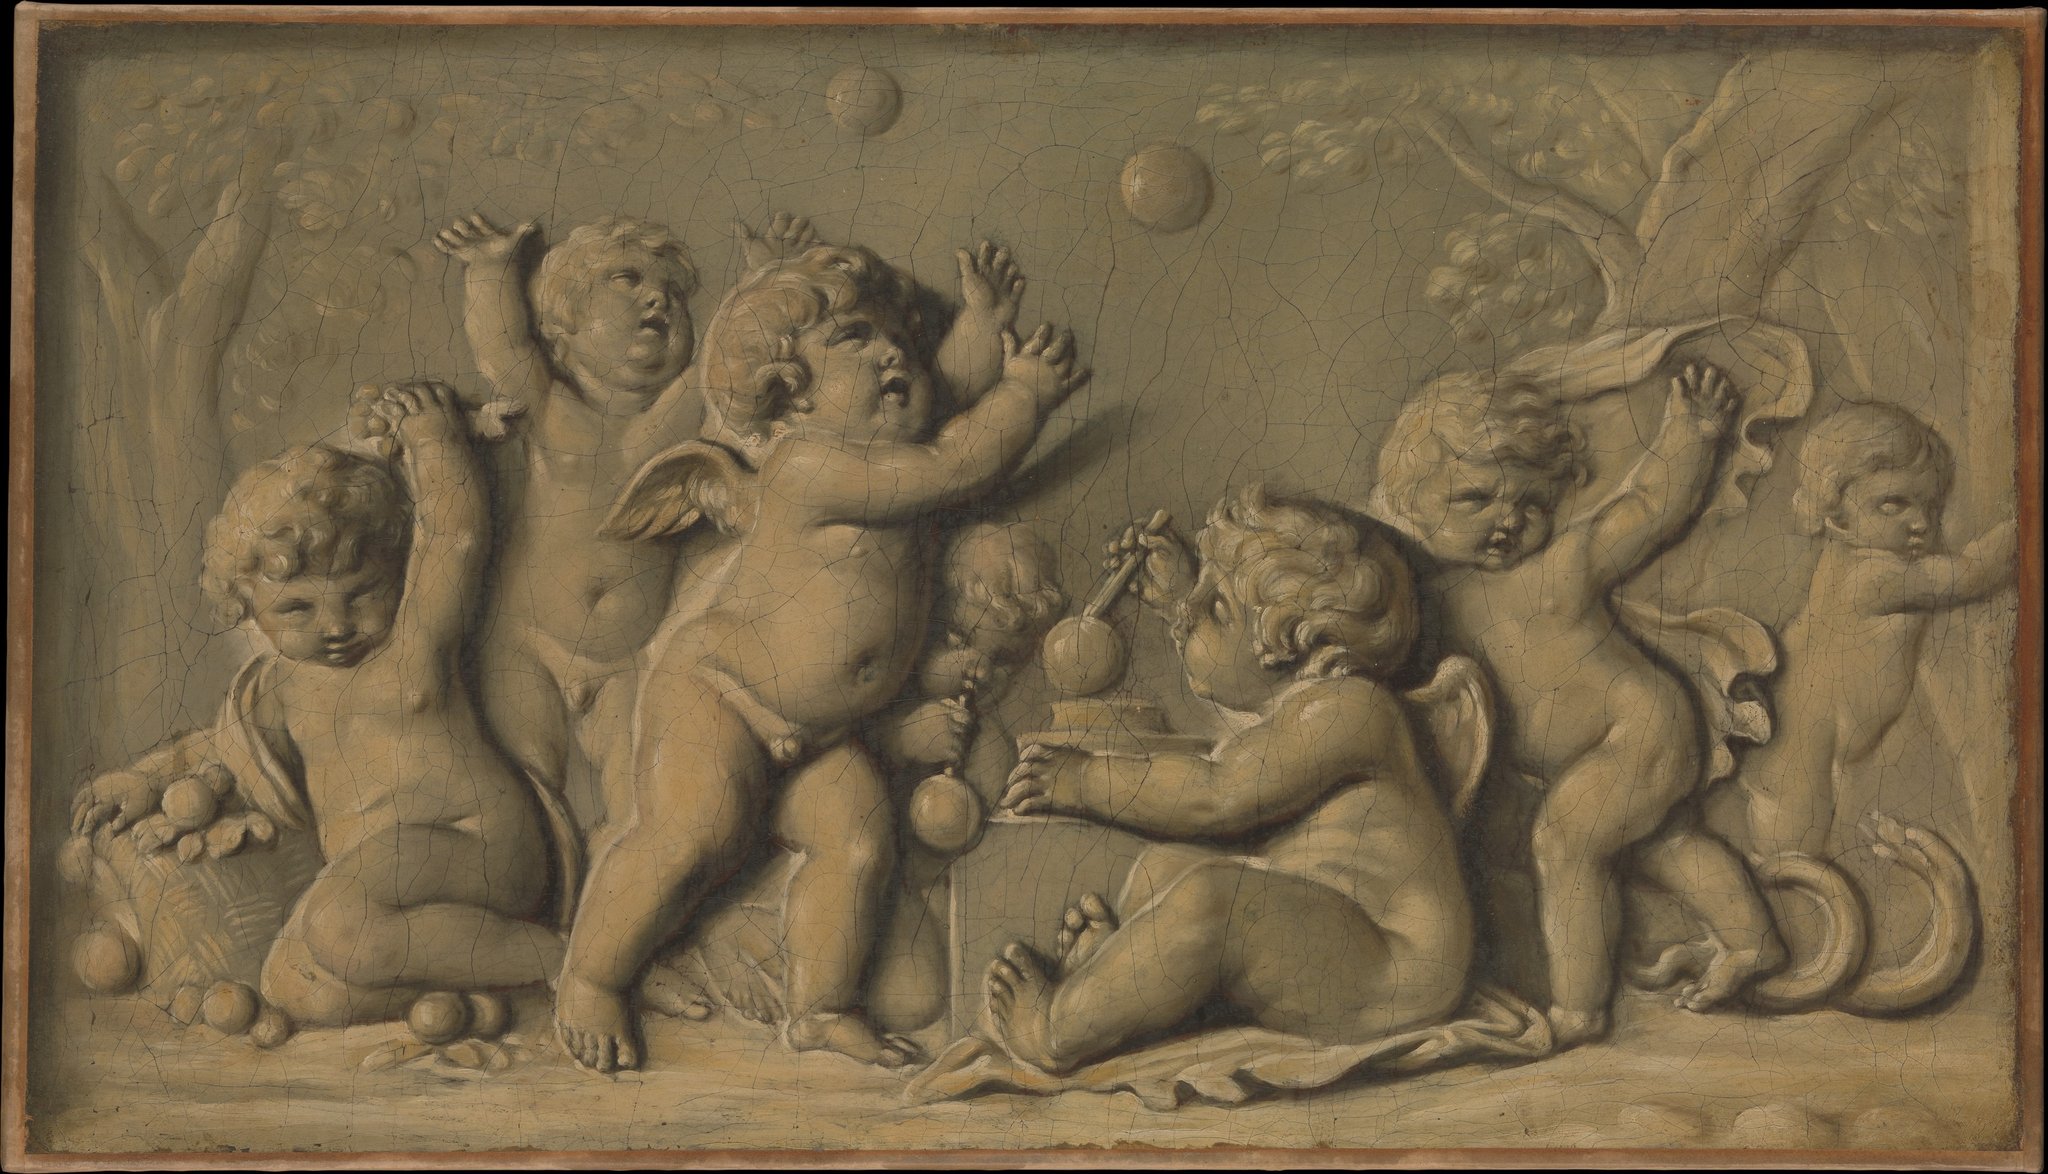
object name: overdoor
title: Amorini at play (one of a pair)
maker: piat joseph sauvage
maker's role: artist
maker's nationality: flemish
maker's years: 1744-1818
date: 1770-1790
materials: canvas, oil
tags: playing,putti